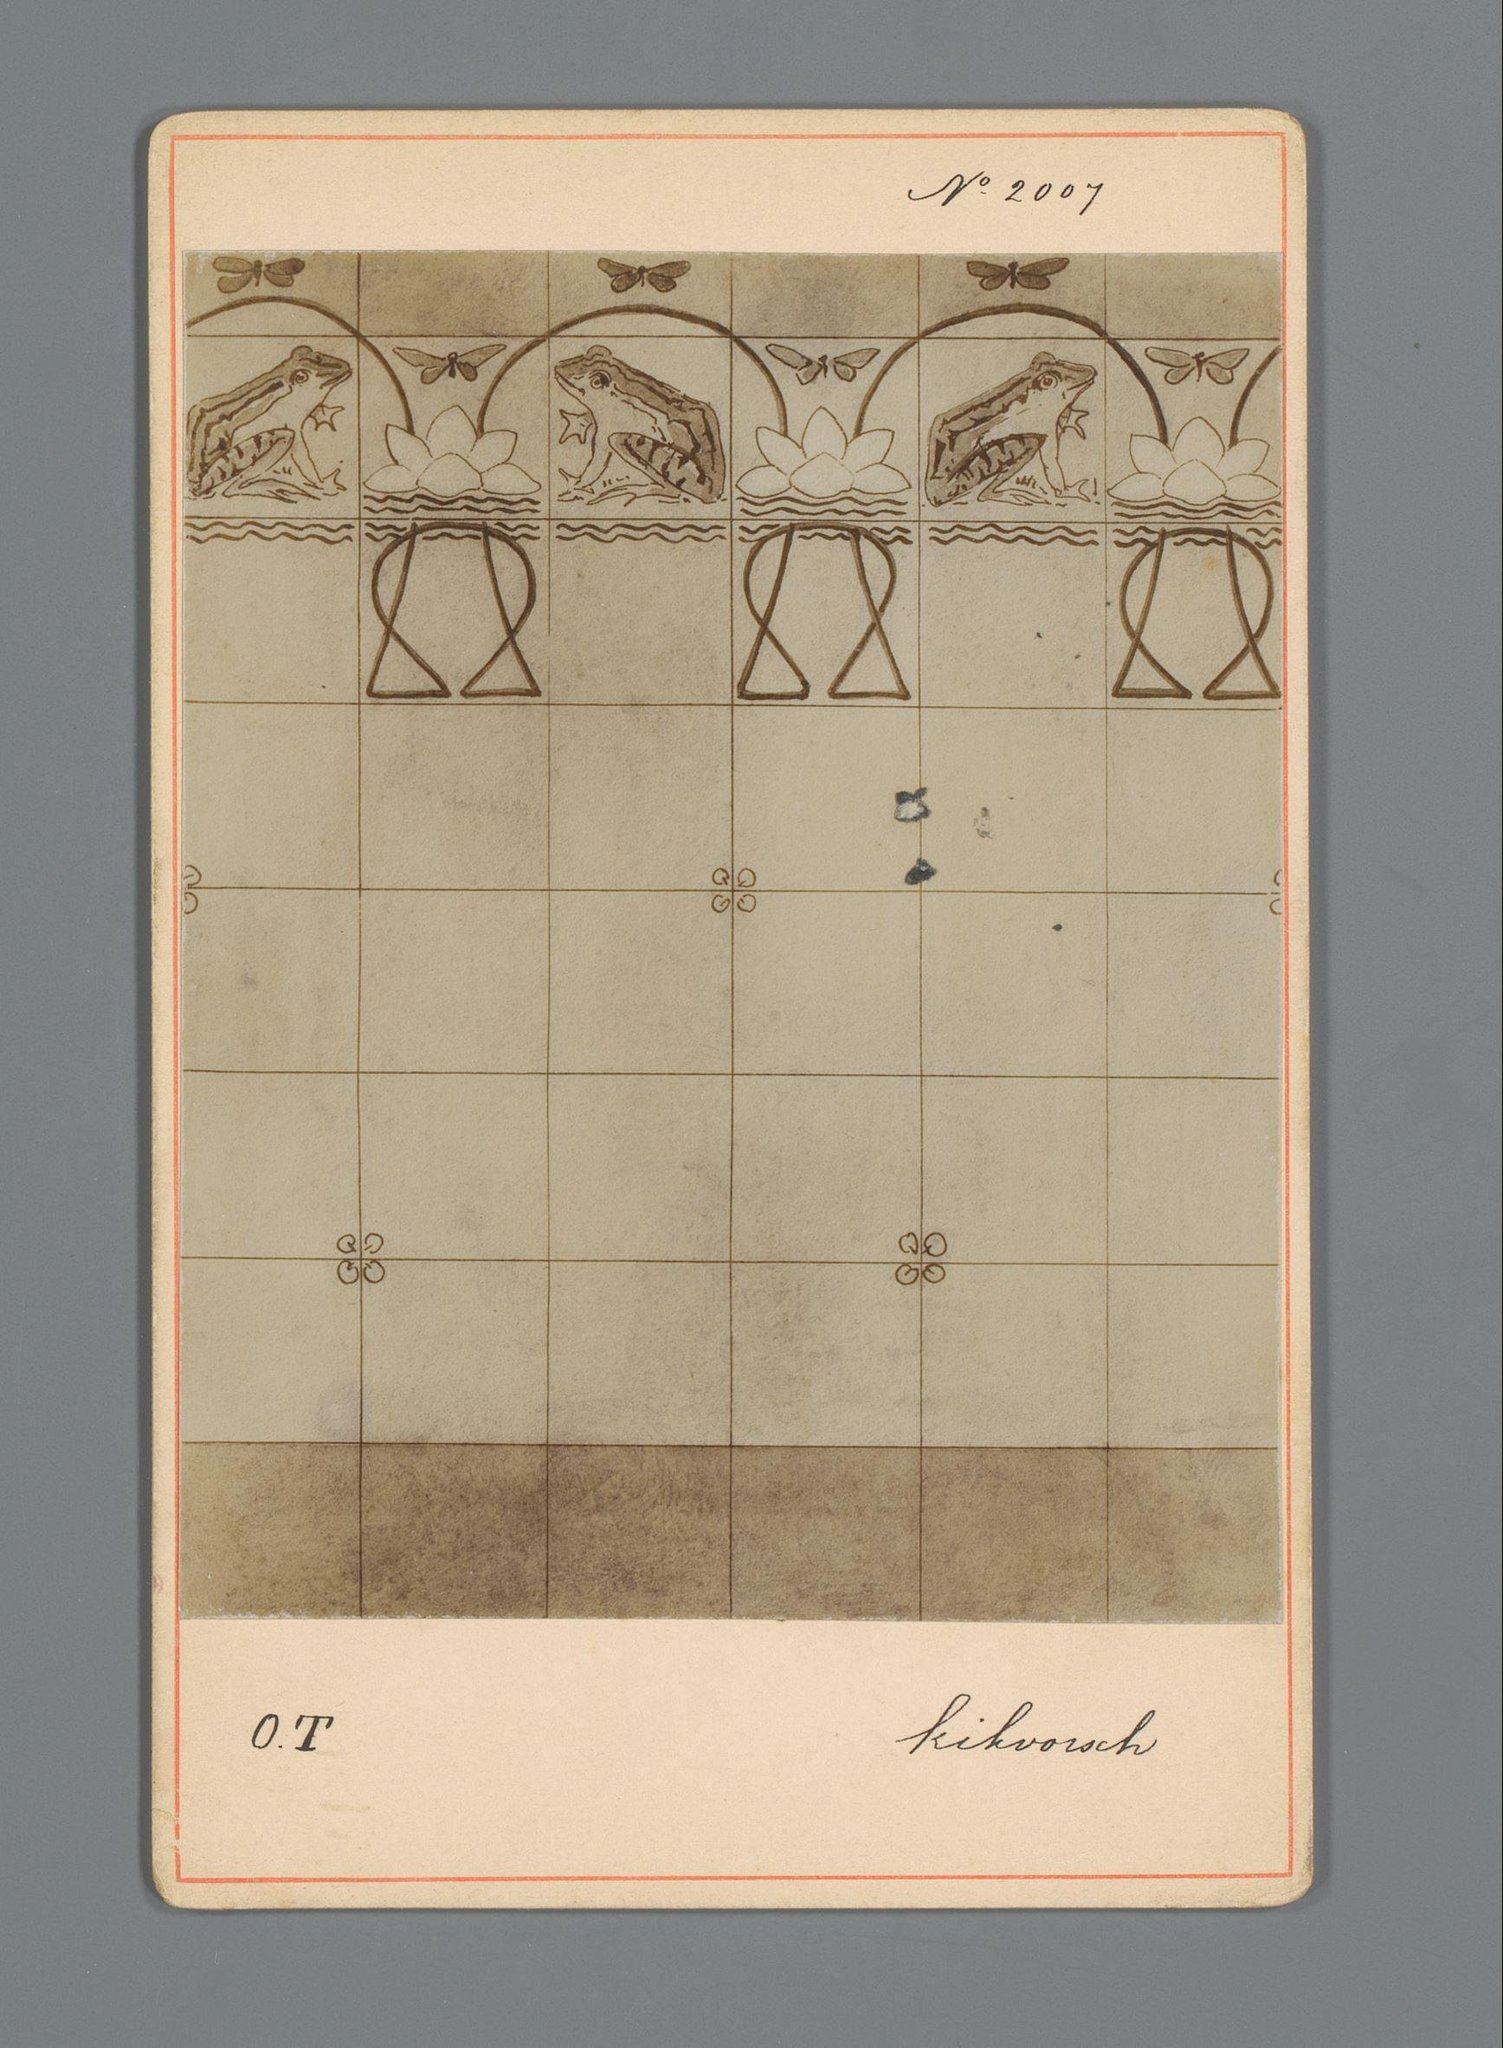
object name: cabinet photograph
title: Tegeltableau met kikkers en waterlelies, reclame voor Fayence en Tegelfabriek Holland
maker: Anonymous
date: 1893-1918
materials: cardboard, photographic support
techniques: collodion silver print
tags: tailless amphibians: frog, flowers: water-lily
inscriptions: inscription: ‘7.15 - Fay/ f 17. - per U/ hoog M 1.12 1/2’, stamp: ‘NAAML. VENN. FAYENCE EN TEGELFABRIEK/ "HOLLAND"’, inscription: ‘O.T.’, number: ‘No. 2007’